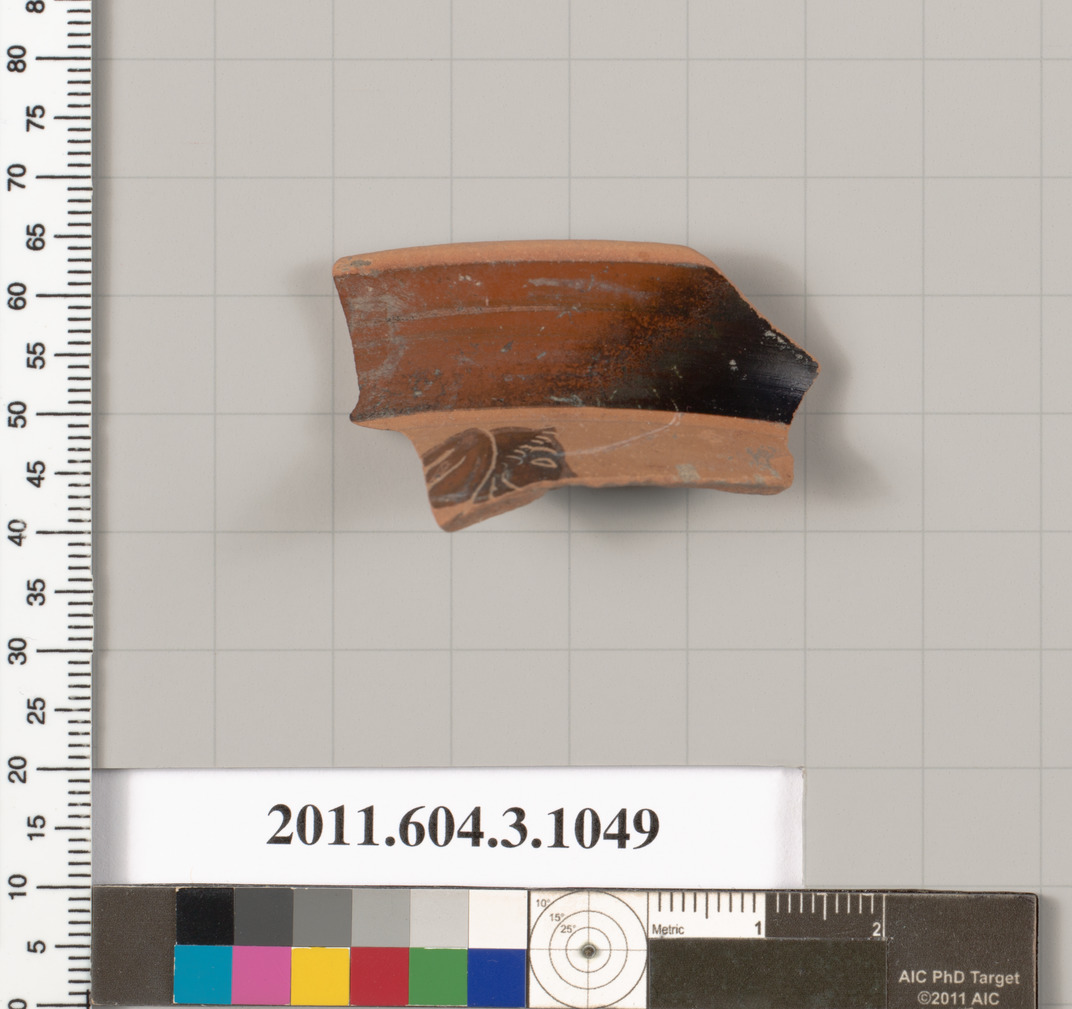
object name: mastoid fragment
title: Terracotta fragment of a mastoid (drinking cup with narrow base)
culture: greek, attic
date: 534-468 BCE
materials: terracotta